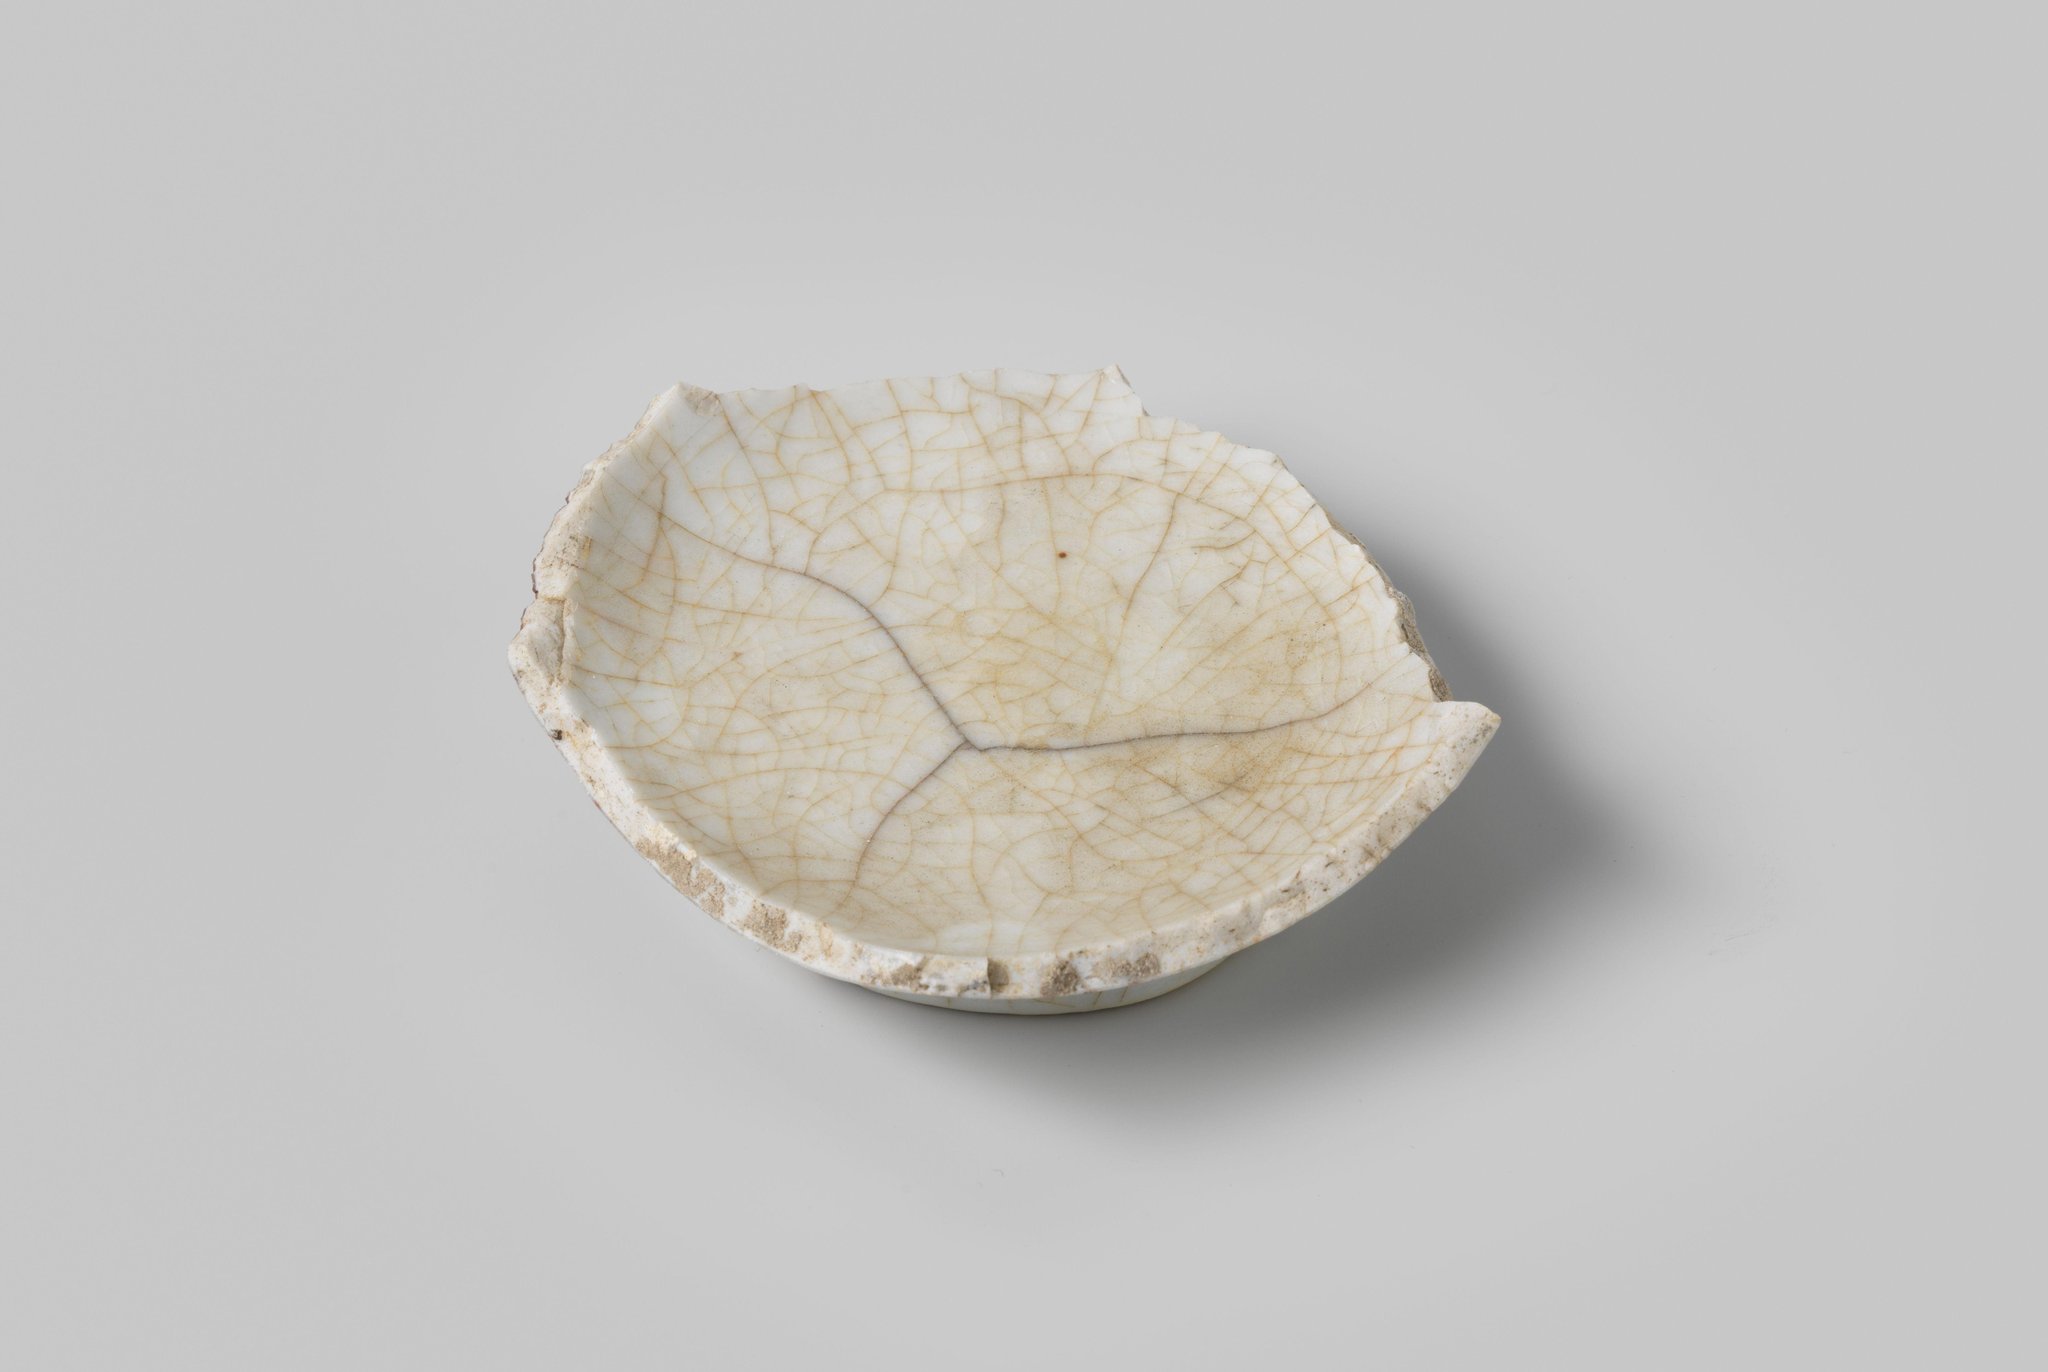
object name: plate dish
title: Fragment bord, gevonden bij V.O.C.-schip Witte Leeuw, mogelijk afkomstig van Zeelelie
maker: Anonymous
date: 1775-1800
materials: porcelain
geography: jingdezhen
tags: verenigde oostindische compagnie, sint-helena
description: Bodem van een bord gemaakt voor export naar Anglo-Saxische landen, Nanking-ceramiek bord. Dit object is 18e-eeuws en kan dus niet van de vracht van de Witte Leeuw zijn. Onduidelijk is of het object van de site komt of dat het later is vermengd, mogelijk met materiaal van de Zeelelie.